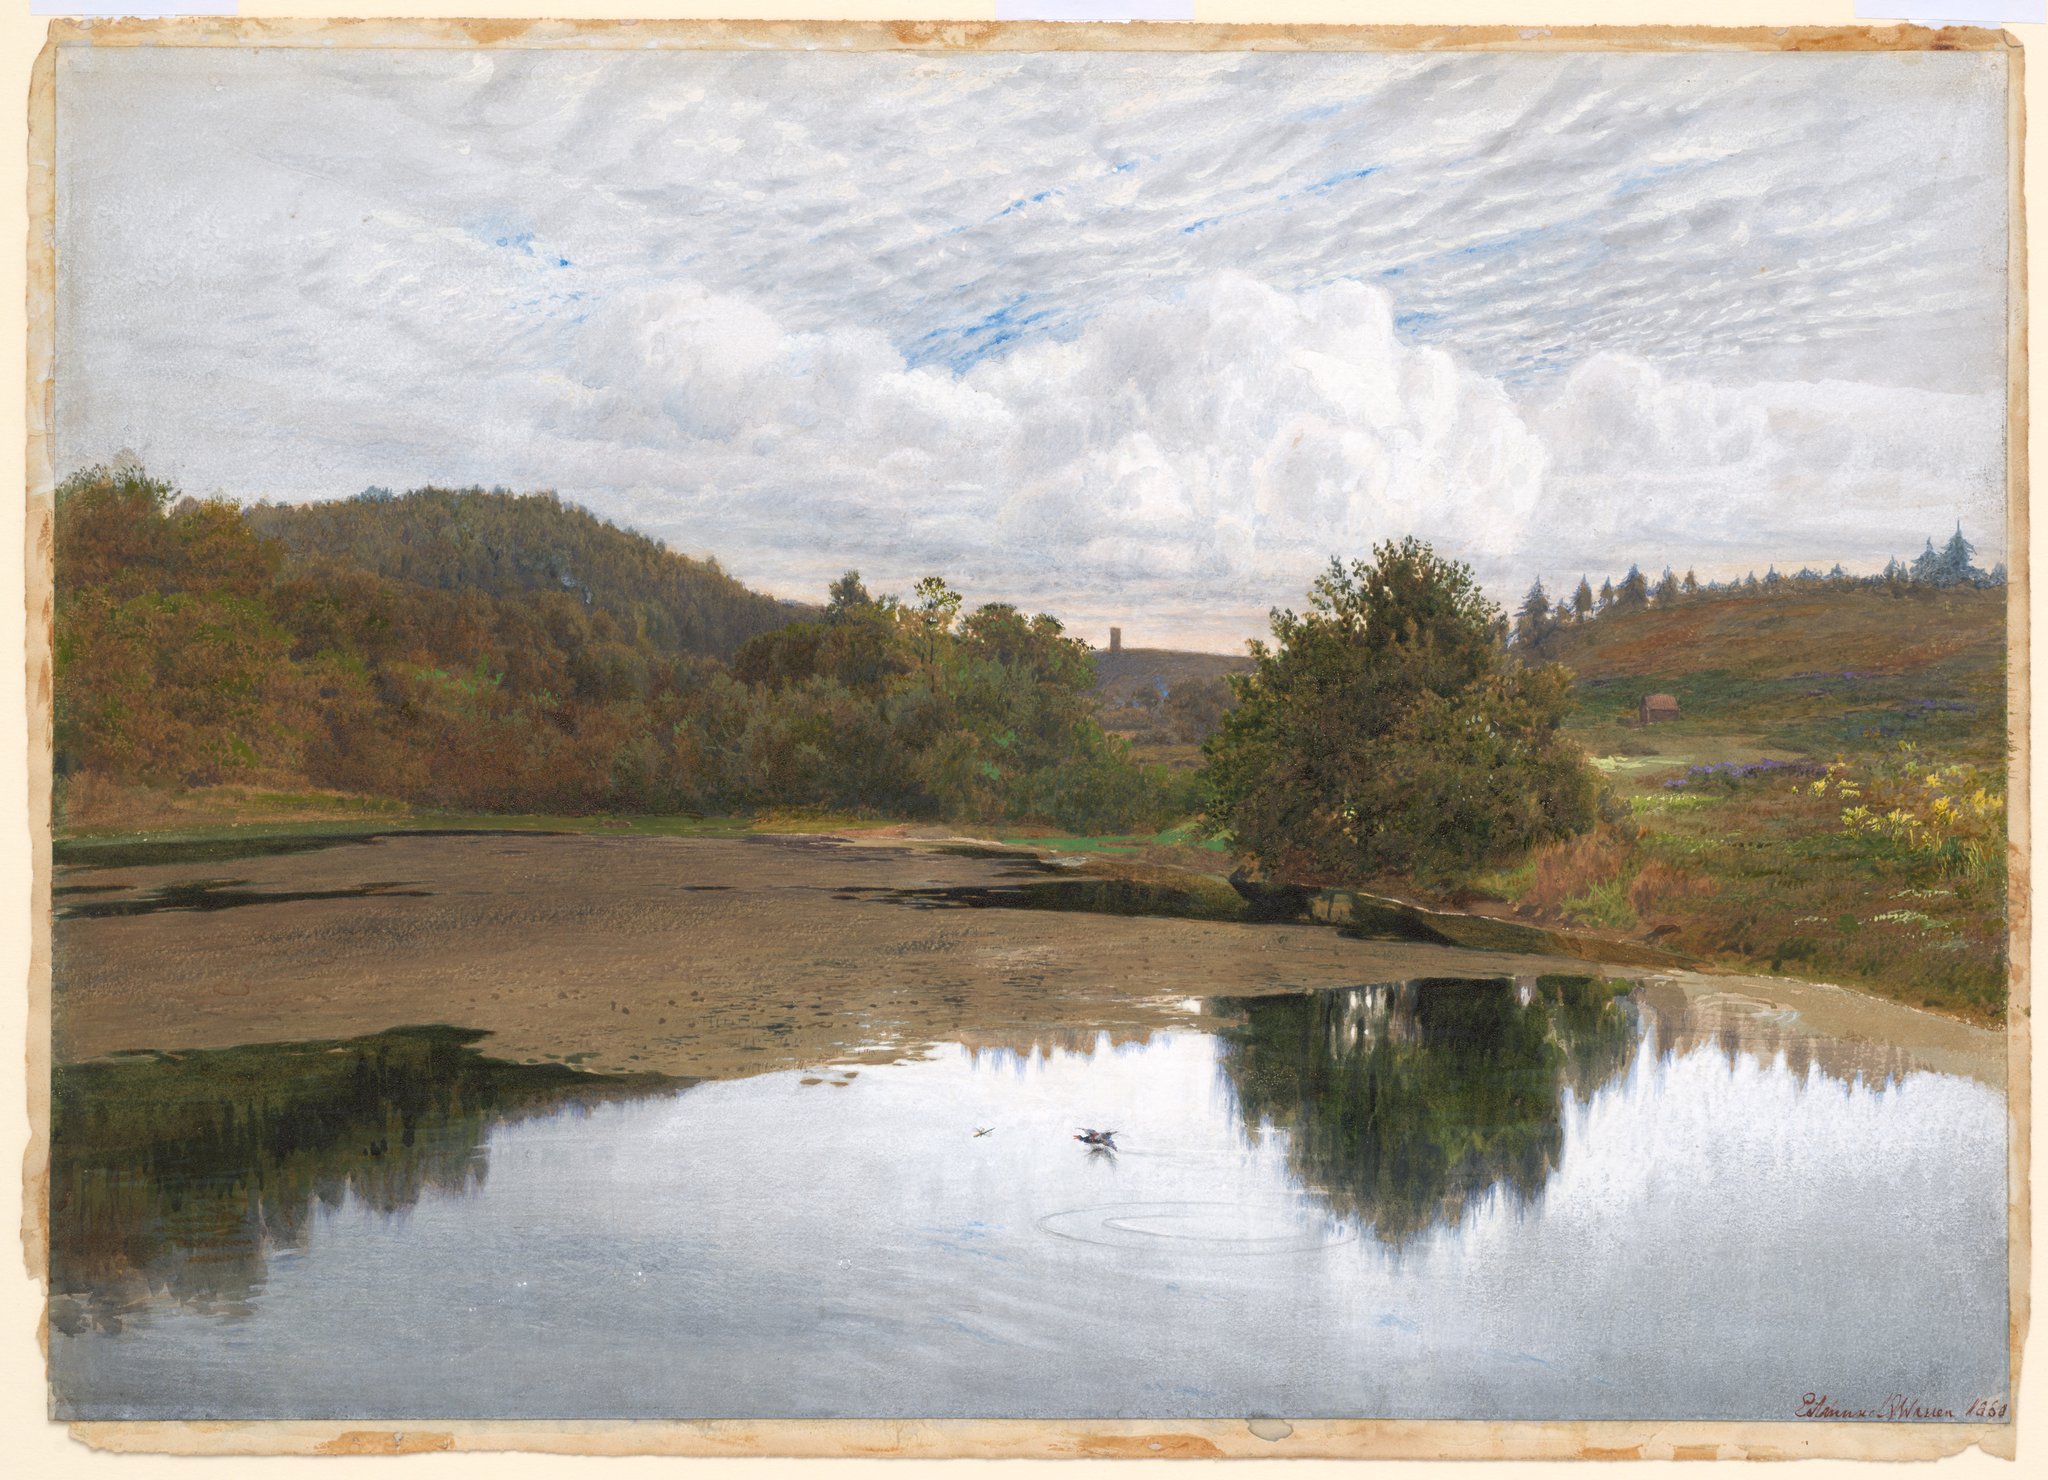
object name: drawing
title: Leith Hill from Broadmoor, Surrey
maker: edmund george warren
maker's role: artist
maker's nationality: british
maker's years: 1834-1909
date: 1860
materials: gum arabic, ink, watercolor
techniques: pen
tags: landscapes